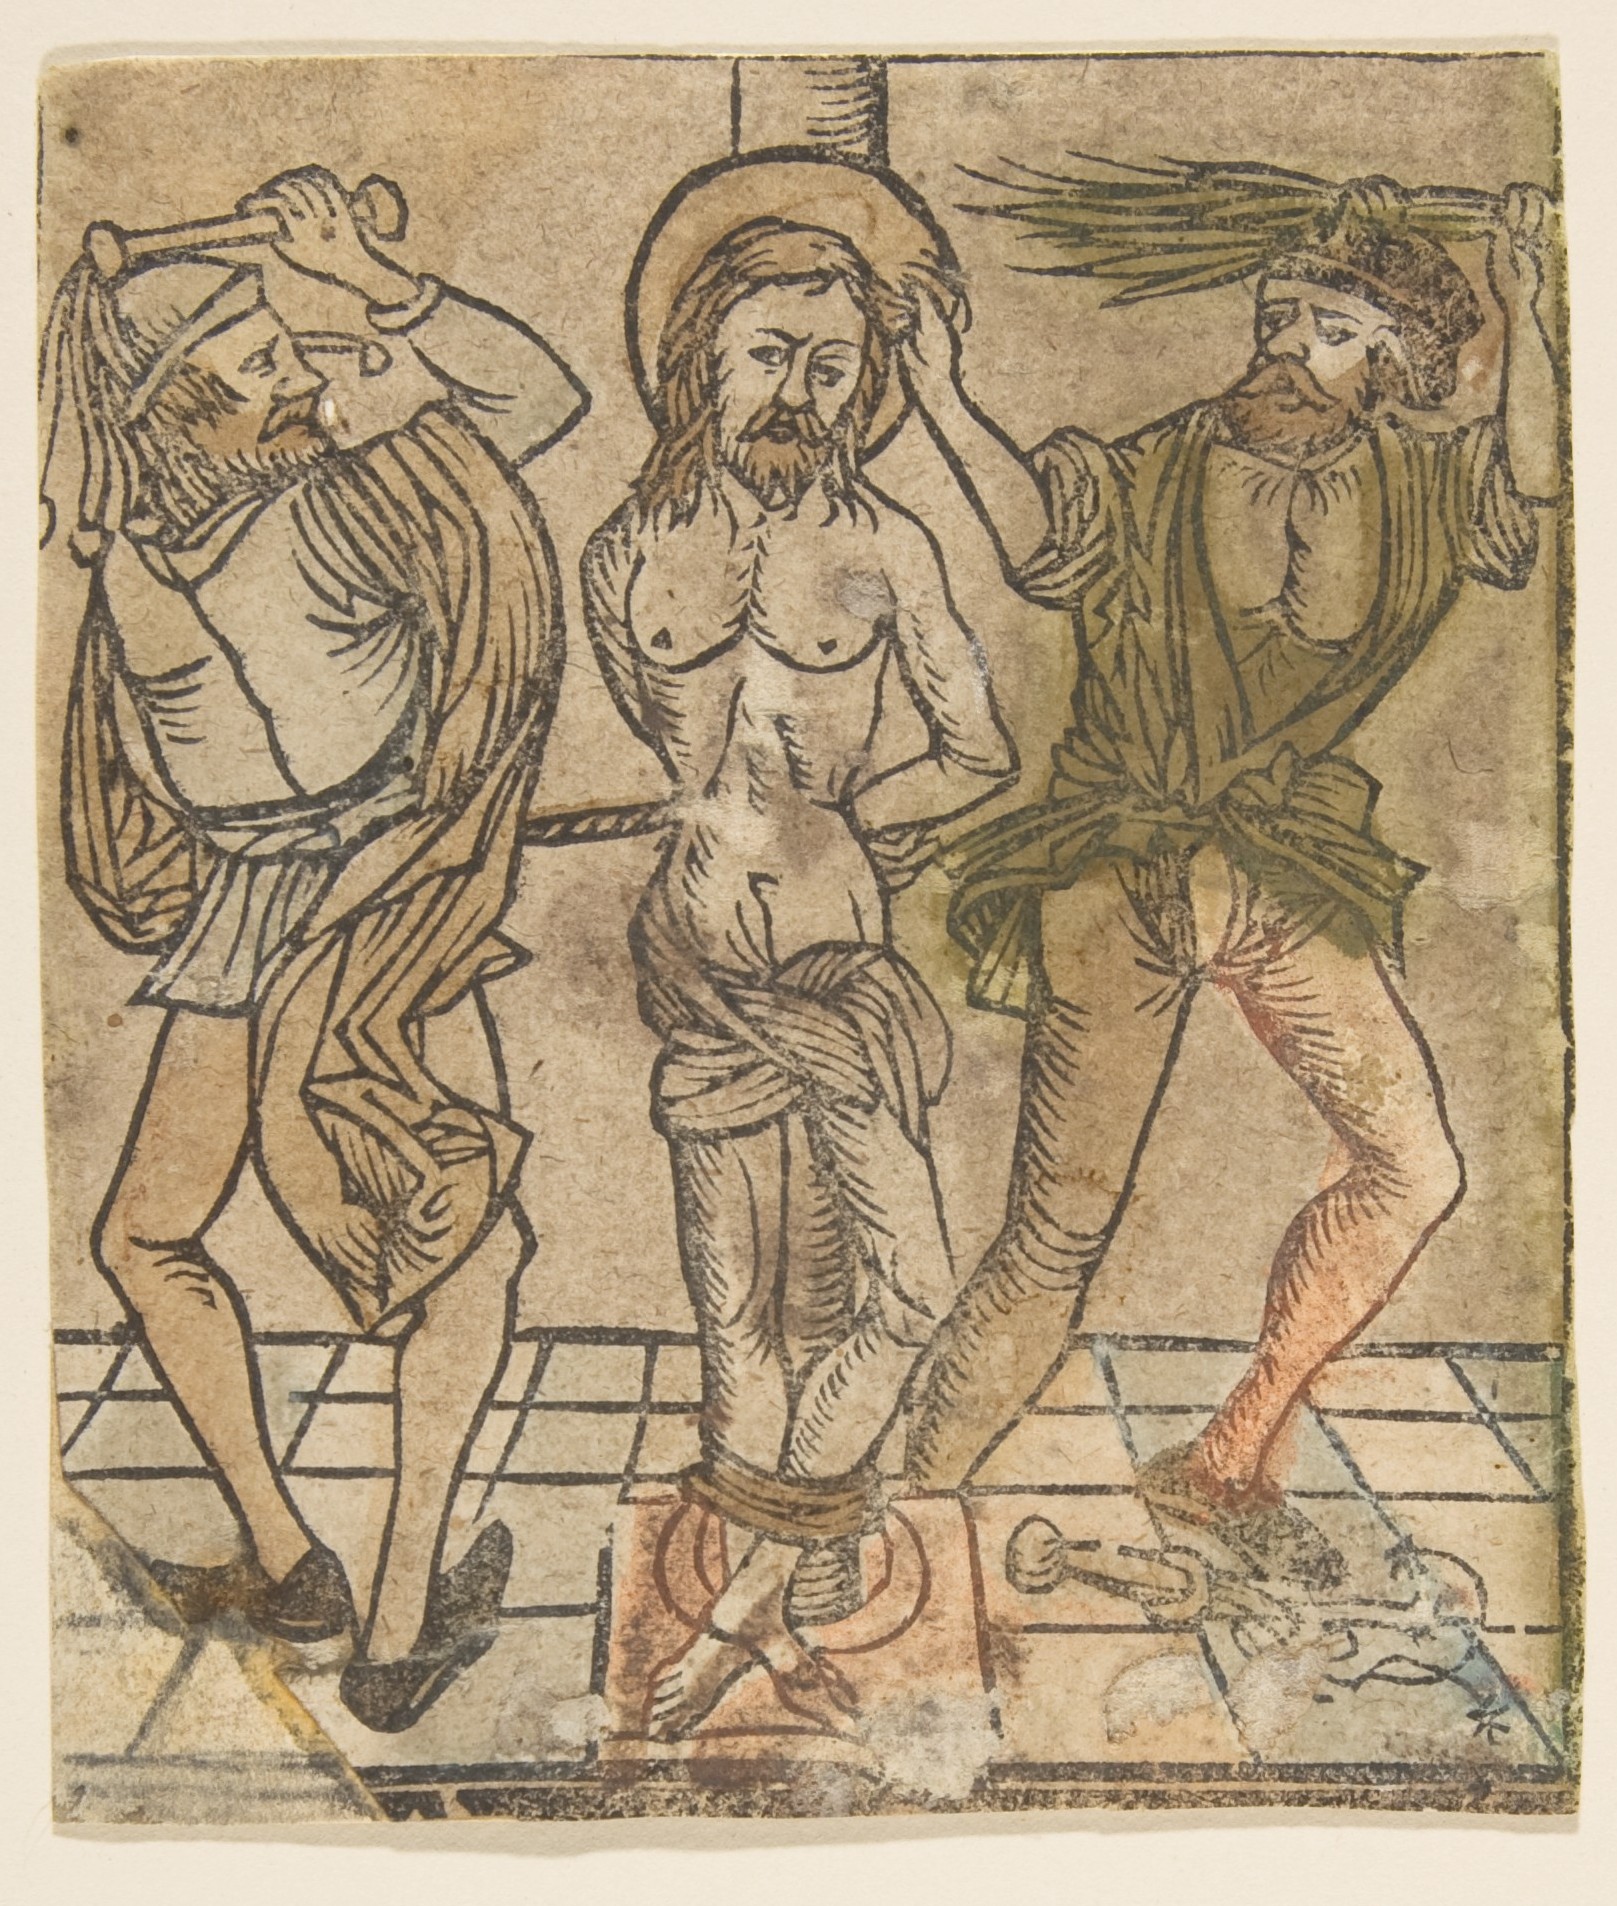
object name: print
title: The Flagellation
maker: anonymous, german, 15th century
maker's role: artist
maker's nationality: german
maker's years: 1400-1500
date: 1401-1500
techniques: hand coloring, woodcut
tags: men,christ